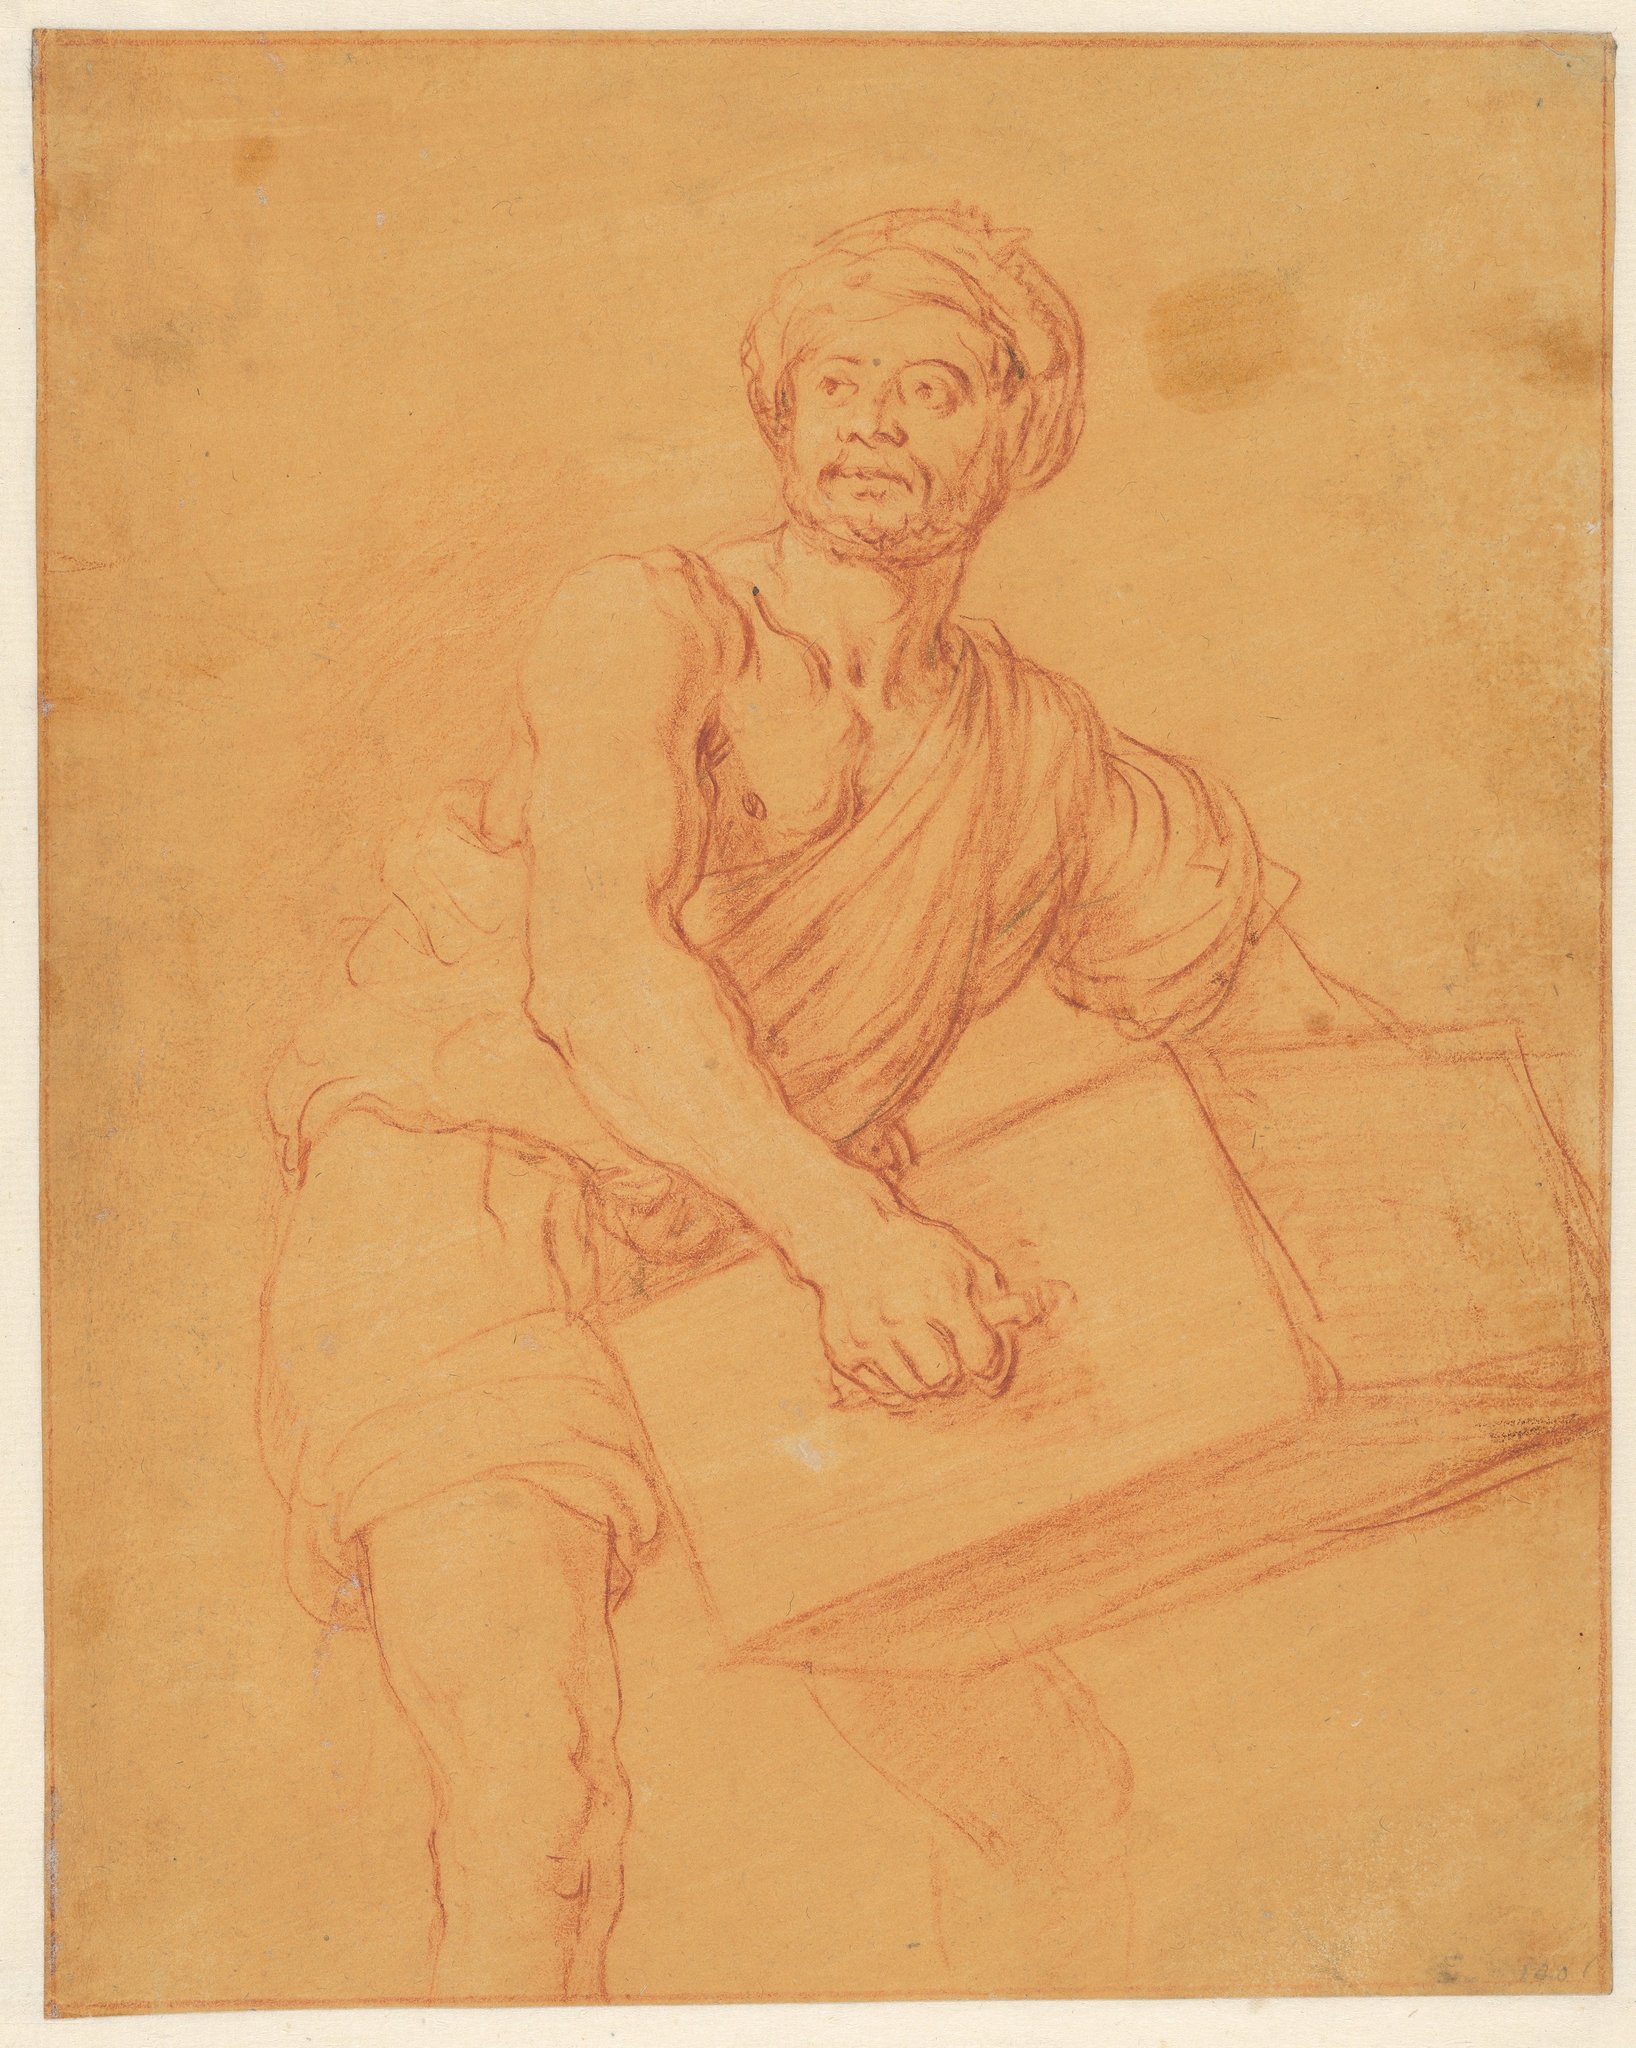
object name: drawing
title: Study of a Bearded and Turbaned Man Carrying a Chest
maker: pieter lastman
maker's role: artist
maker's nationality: dutch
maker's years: 1583-1633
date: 1625-1630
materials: chalk, paper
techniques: heightening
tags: men,chests